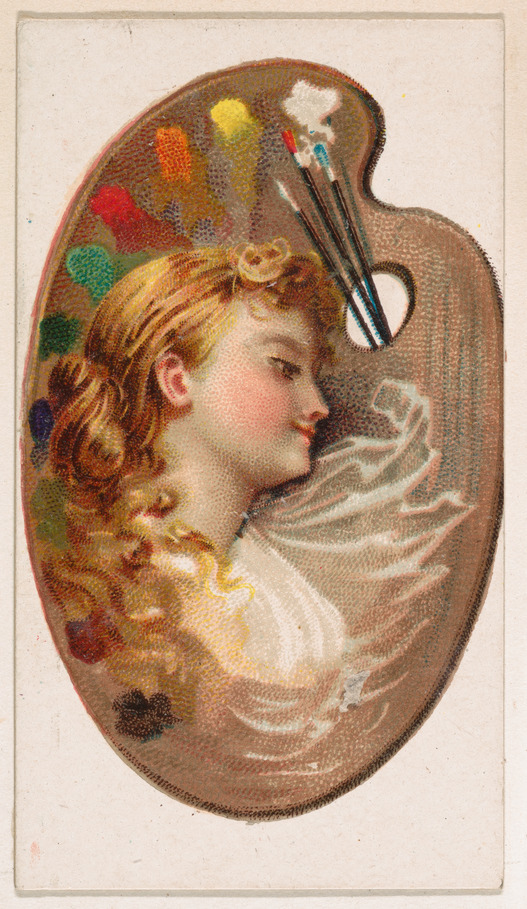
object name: print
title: Artist's pallette, from the Novelties series (N228, Type 5) issued by Kinney Bros.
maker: kinney brothers tobacco company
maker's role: publisher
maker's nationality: american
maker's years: 1869-2011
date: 1889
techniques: color lithograph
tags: women